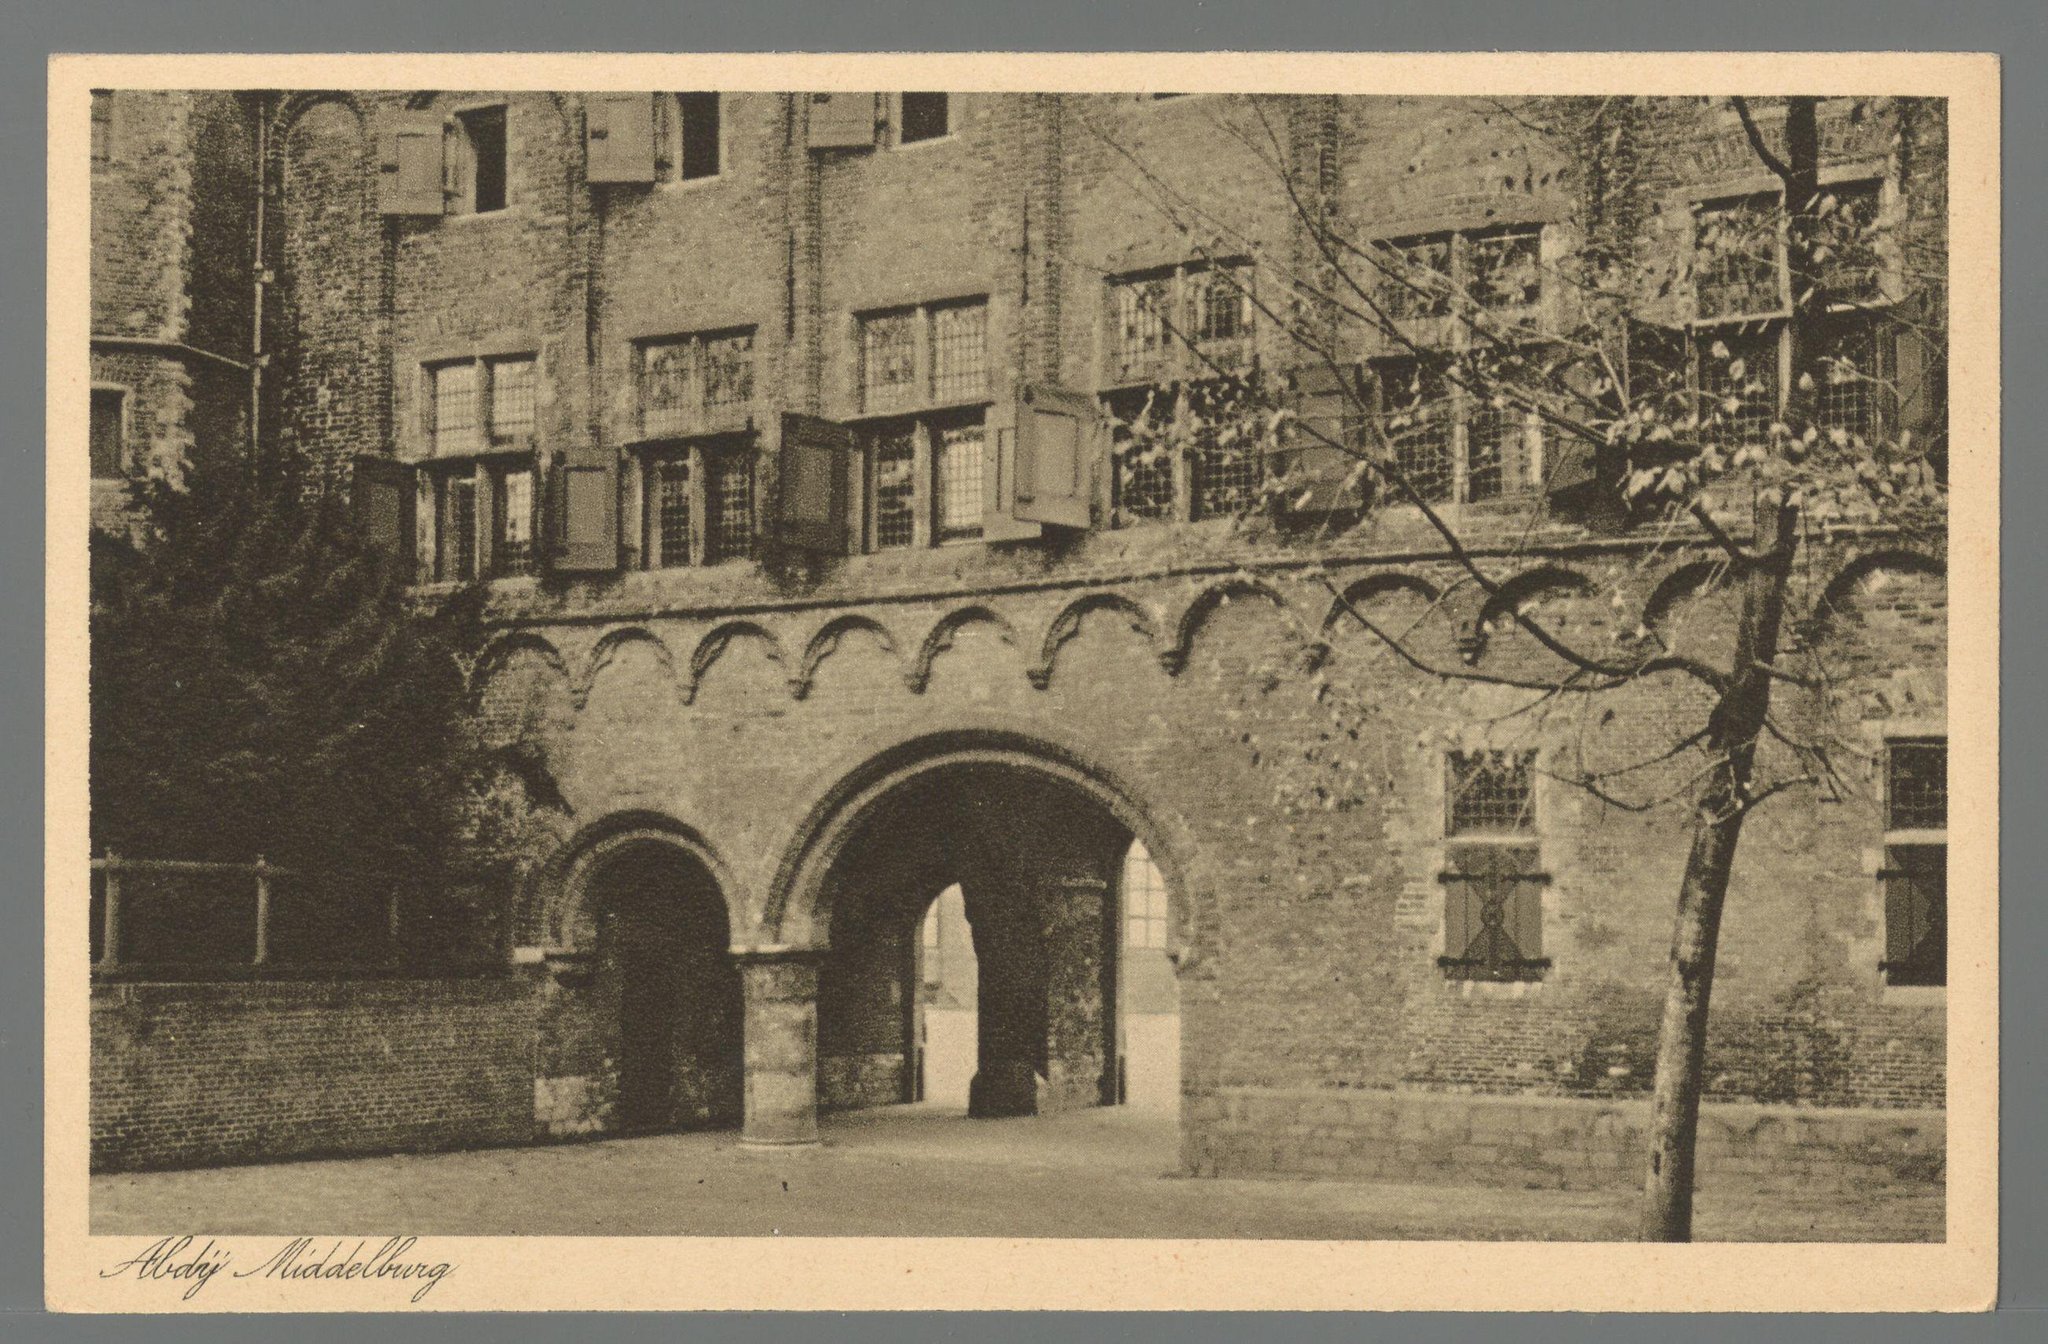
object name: ansichtkaart, prentbriefkaart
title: Abdij Middelburg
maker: Anonymous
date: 1905-1930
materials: cardboard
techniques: rotogravure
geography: middelburg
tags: abbey, monastery, convent ~ roman catholic church